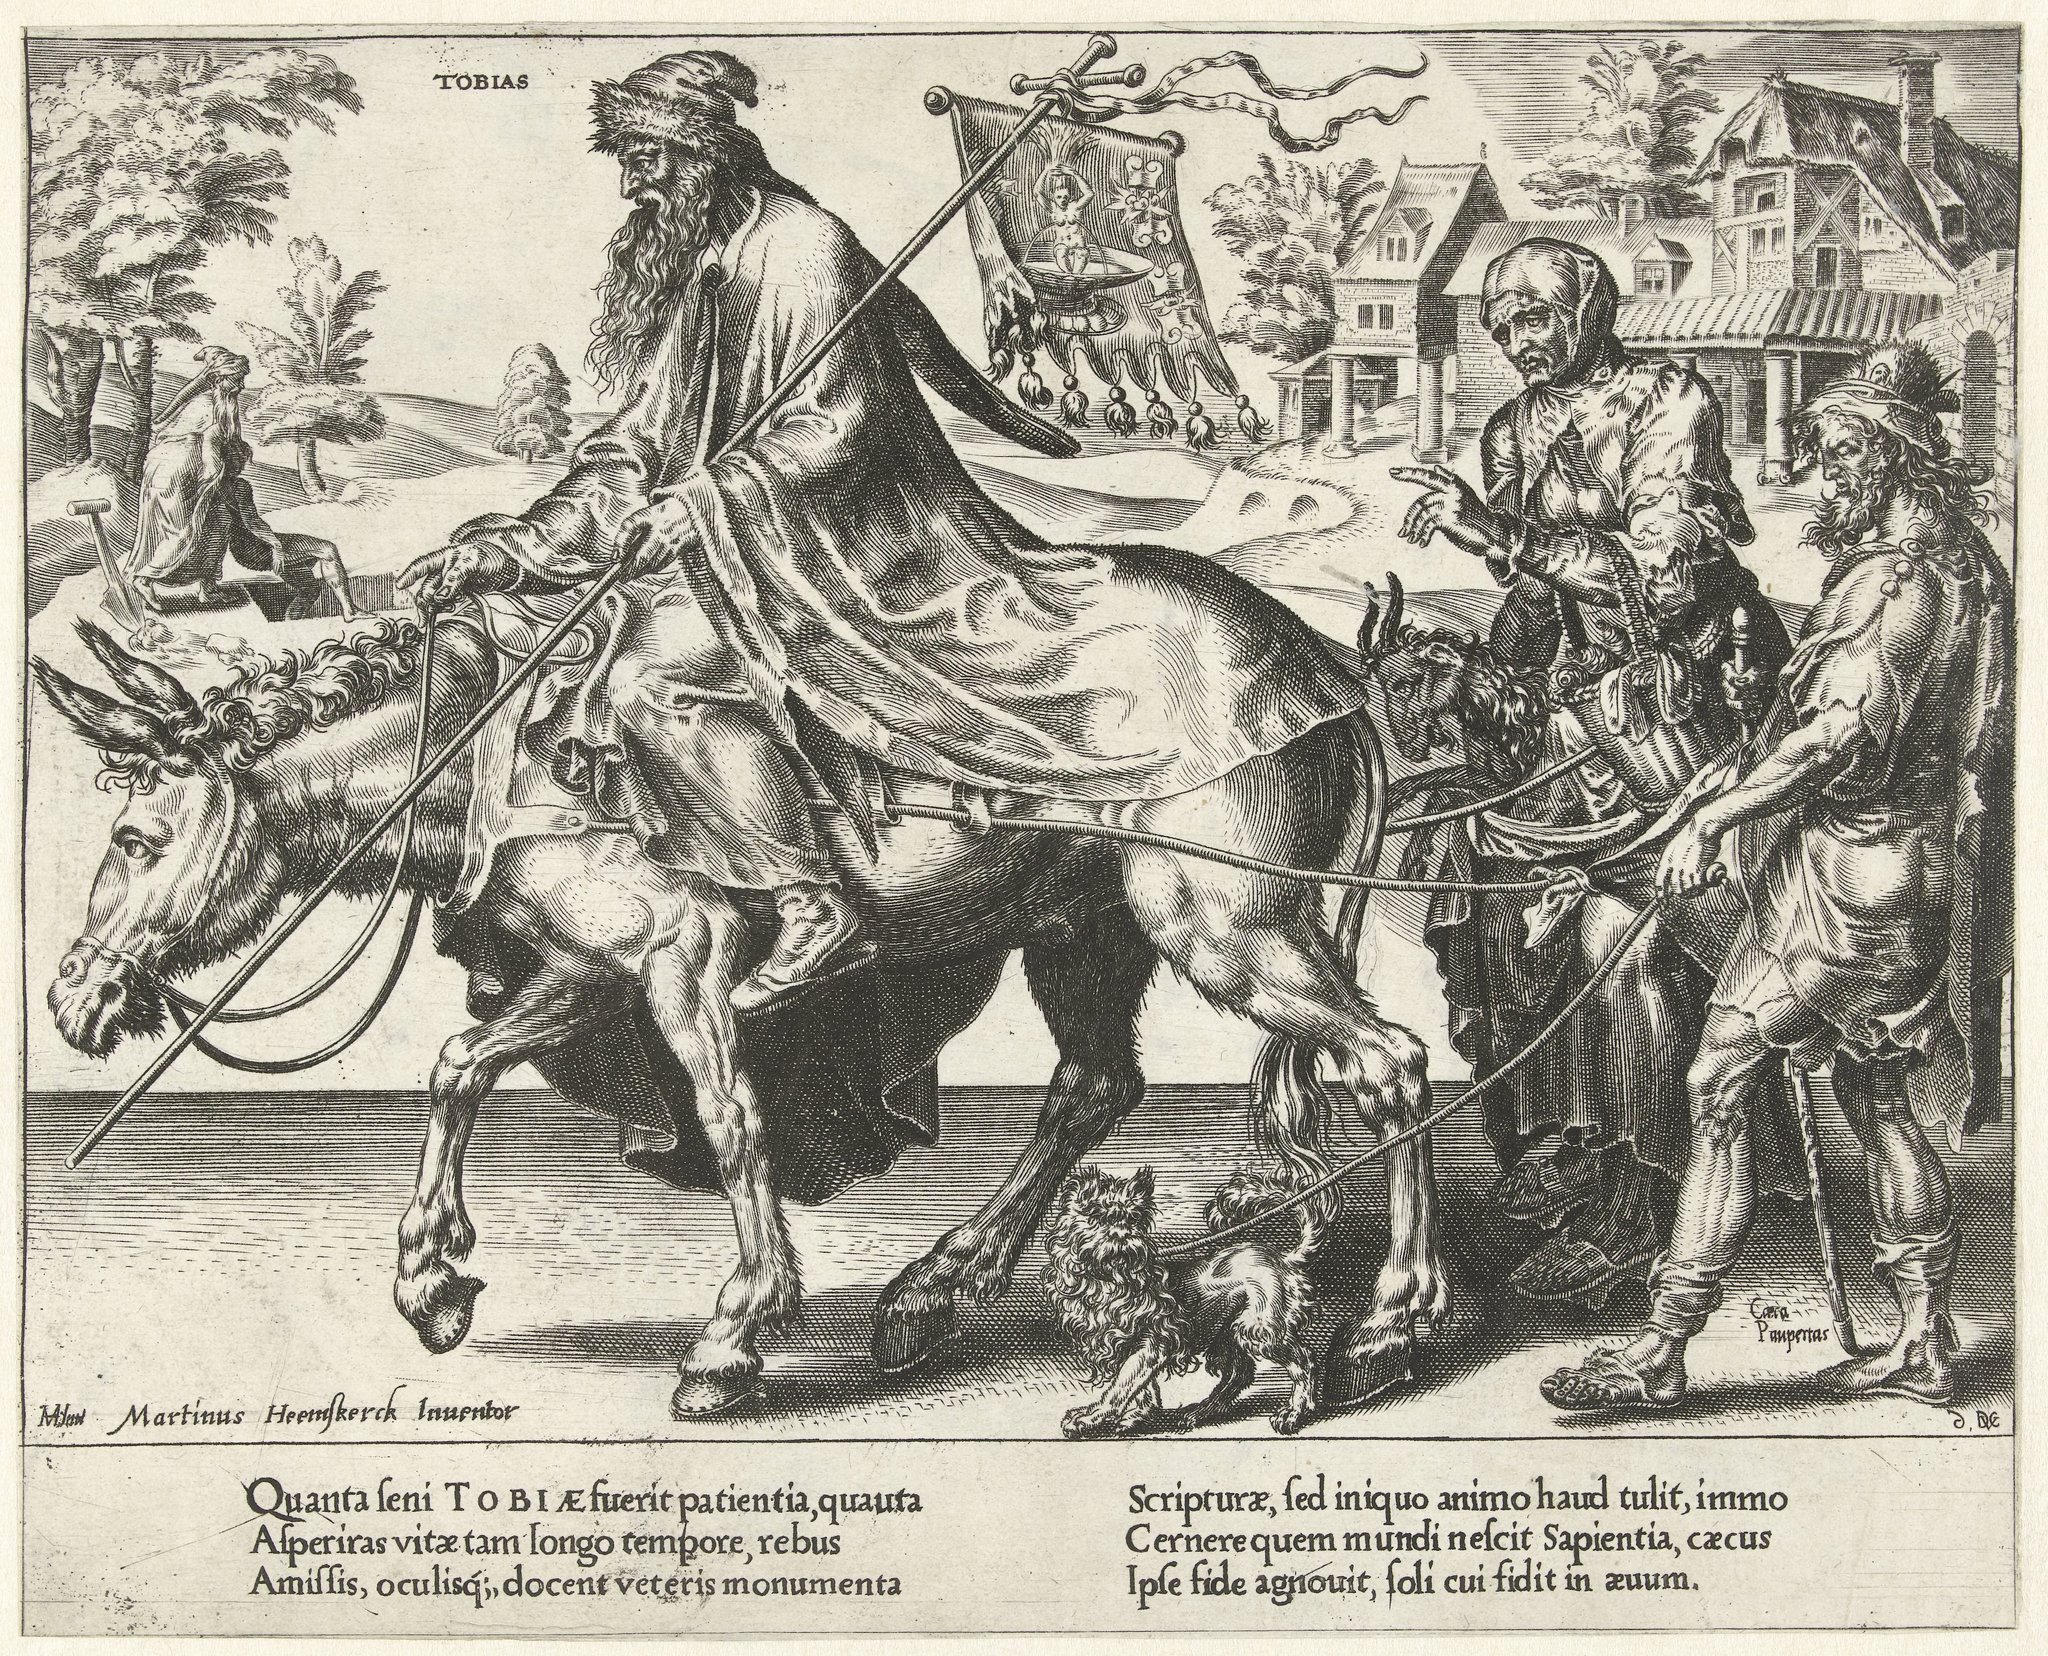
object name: print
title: Triomf van Tobias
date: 1559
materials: paper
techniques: engraving, etching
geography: antwerp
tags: tortoises, turtles, ass, donkey, triumphs (allegorical and symbolic), tobit buries the dead in secret, anna brings home a young goat: tobit thinks she has stolen it, poverty; 'povertà', 'povertà del doni', 'povertà in uno ch'habbia bell'ingegno' (ripa), male persons from the old testament (with name) (not in biblical context)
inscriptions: collector's mark: Lugt 2228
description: Op de voorgrond Tobias, rijdend op een ezel. In zijn linkerhand een kruis met een vaandel. Op het vaandel vier vuurijzers, met in het midden het symbool van barmhartigheid, een fontein in de vorm van een vrouw. Achter Tobias volgen zijn vrouw (met een bokje) en Blinde Armoede (Caecas Paupertas). De prent heeft een Latijns onderschrift van zes regels en maakt deel uit van een achtdelige serie over de triomf van de Lijdzaamheid.